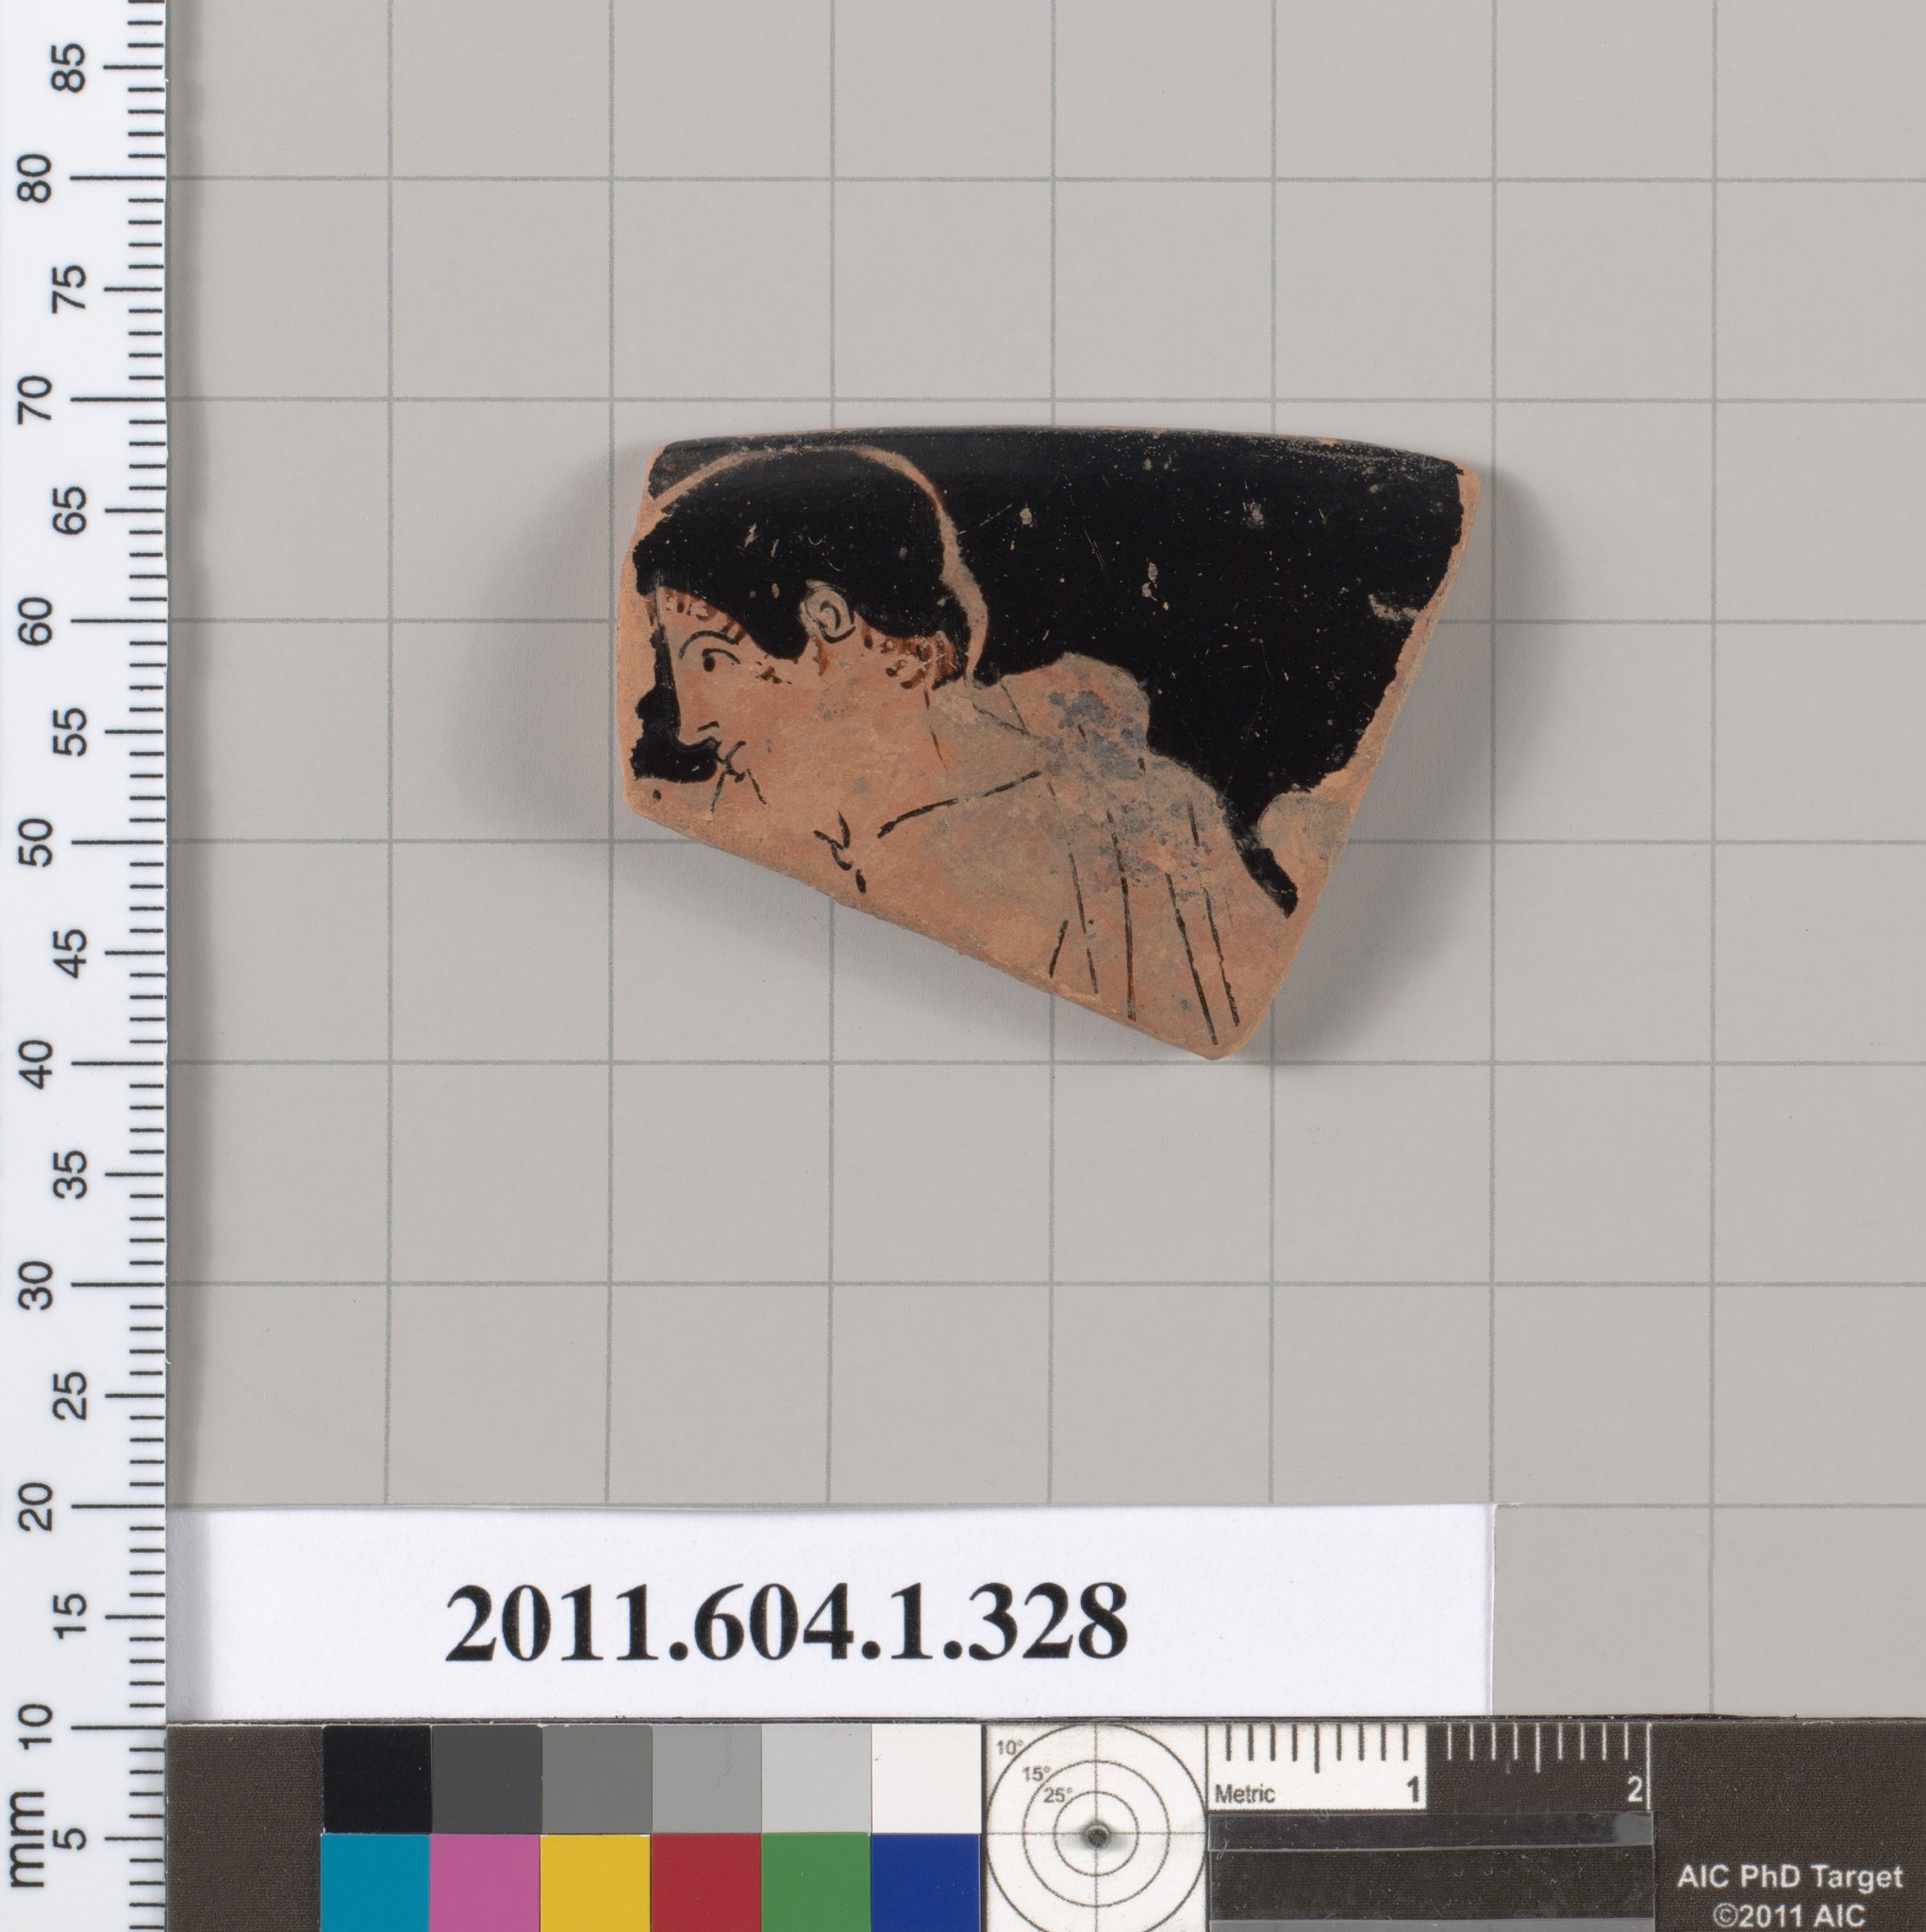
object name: kylix fragment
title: Terracotta rim fragment of a kylix (drinking cup)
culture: greek, attic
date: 475-451 BCE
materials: terracotta